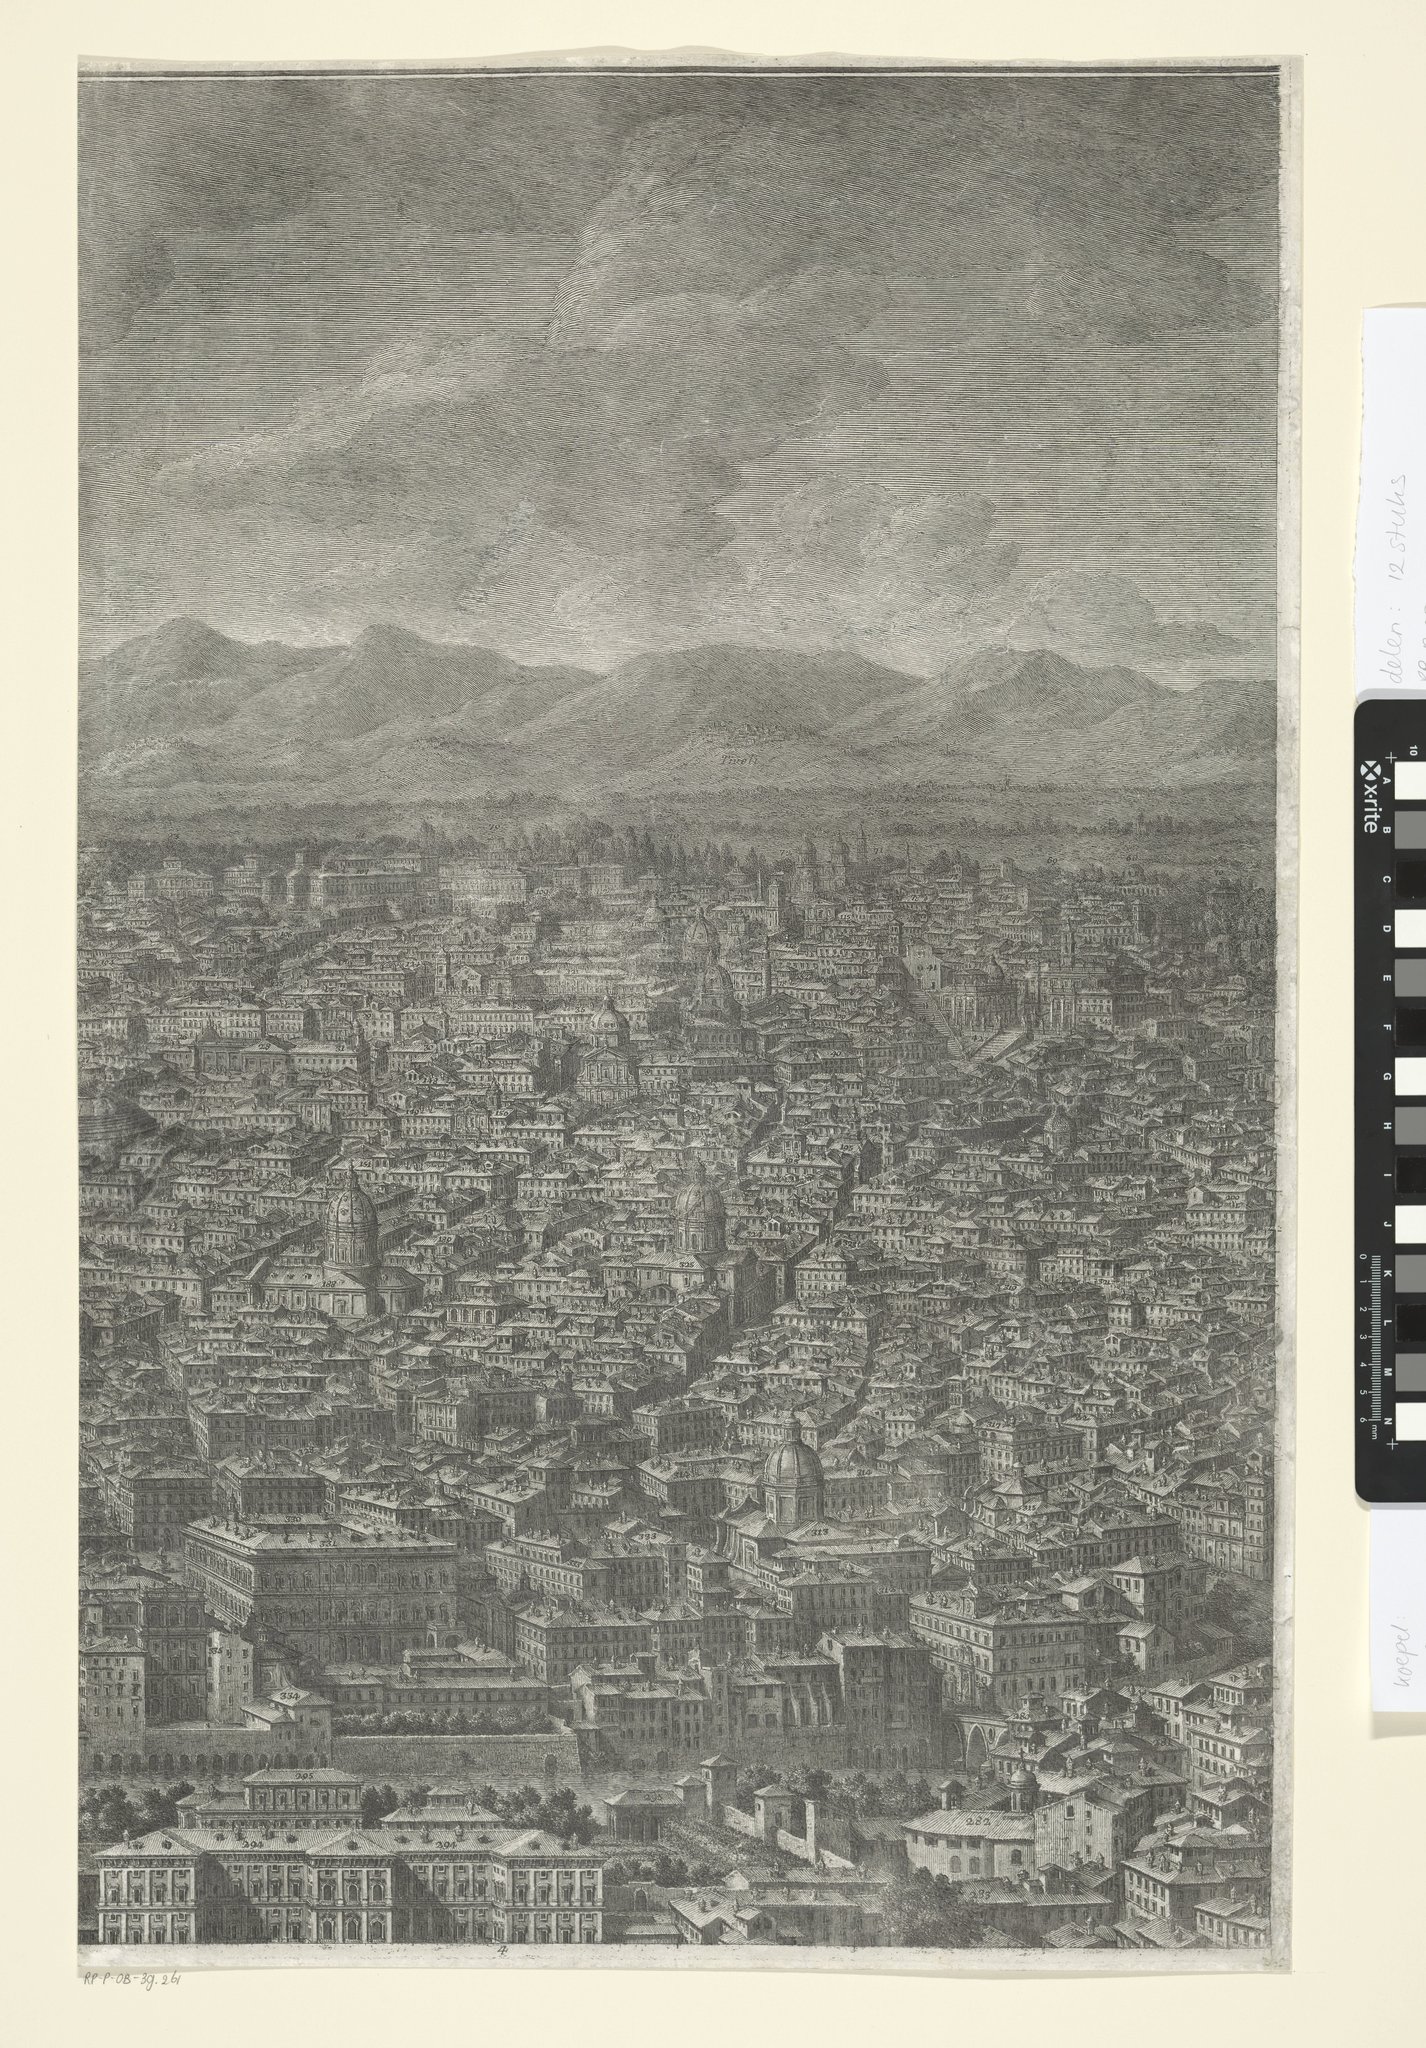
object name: print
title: Prospetto d. alma città di Rom (...)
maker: giuseppe vasi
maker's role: draughtsman, painter, print maker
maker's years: 1710-1782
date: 1765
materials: paper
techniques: etching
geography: rome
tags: panorama, cyclorama, city-view in general; 'veduta', rome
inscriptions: collector's mark: Lugt 2228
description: Deel van een panorama van de stad Rome, gezien vanaf de Janiculum heuvel.